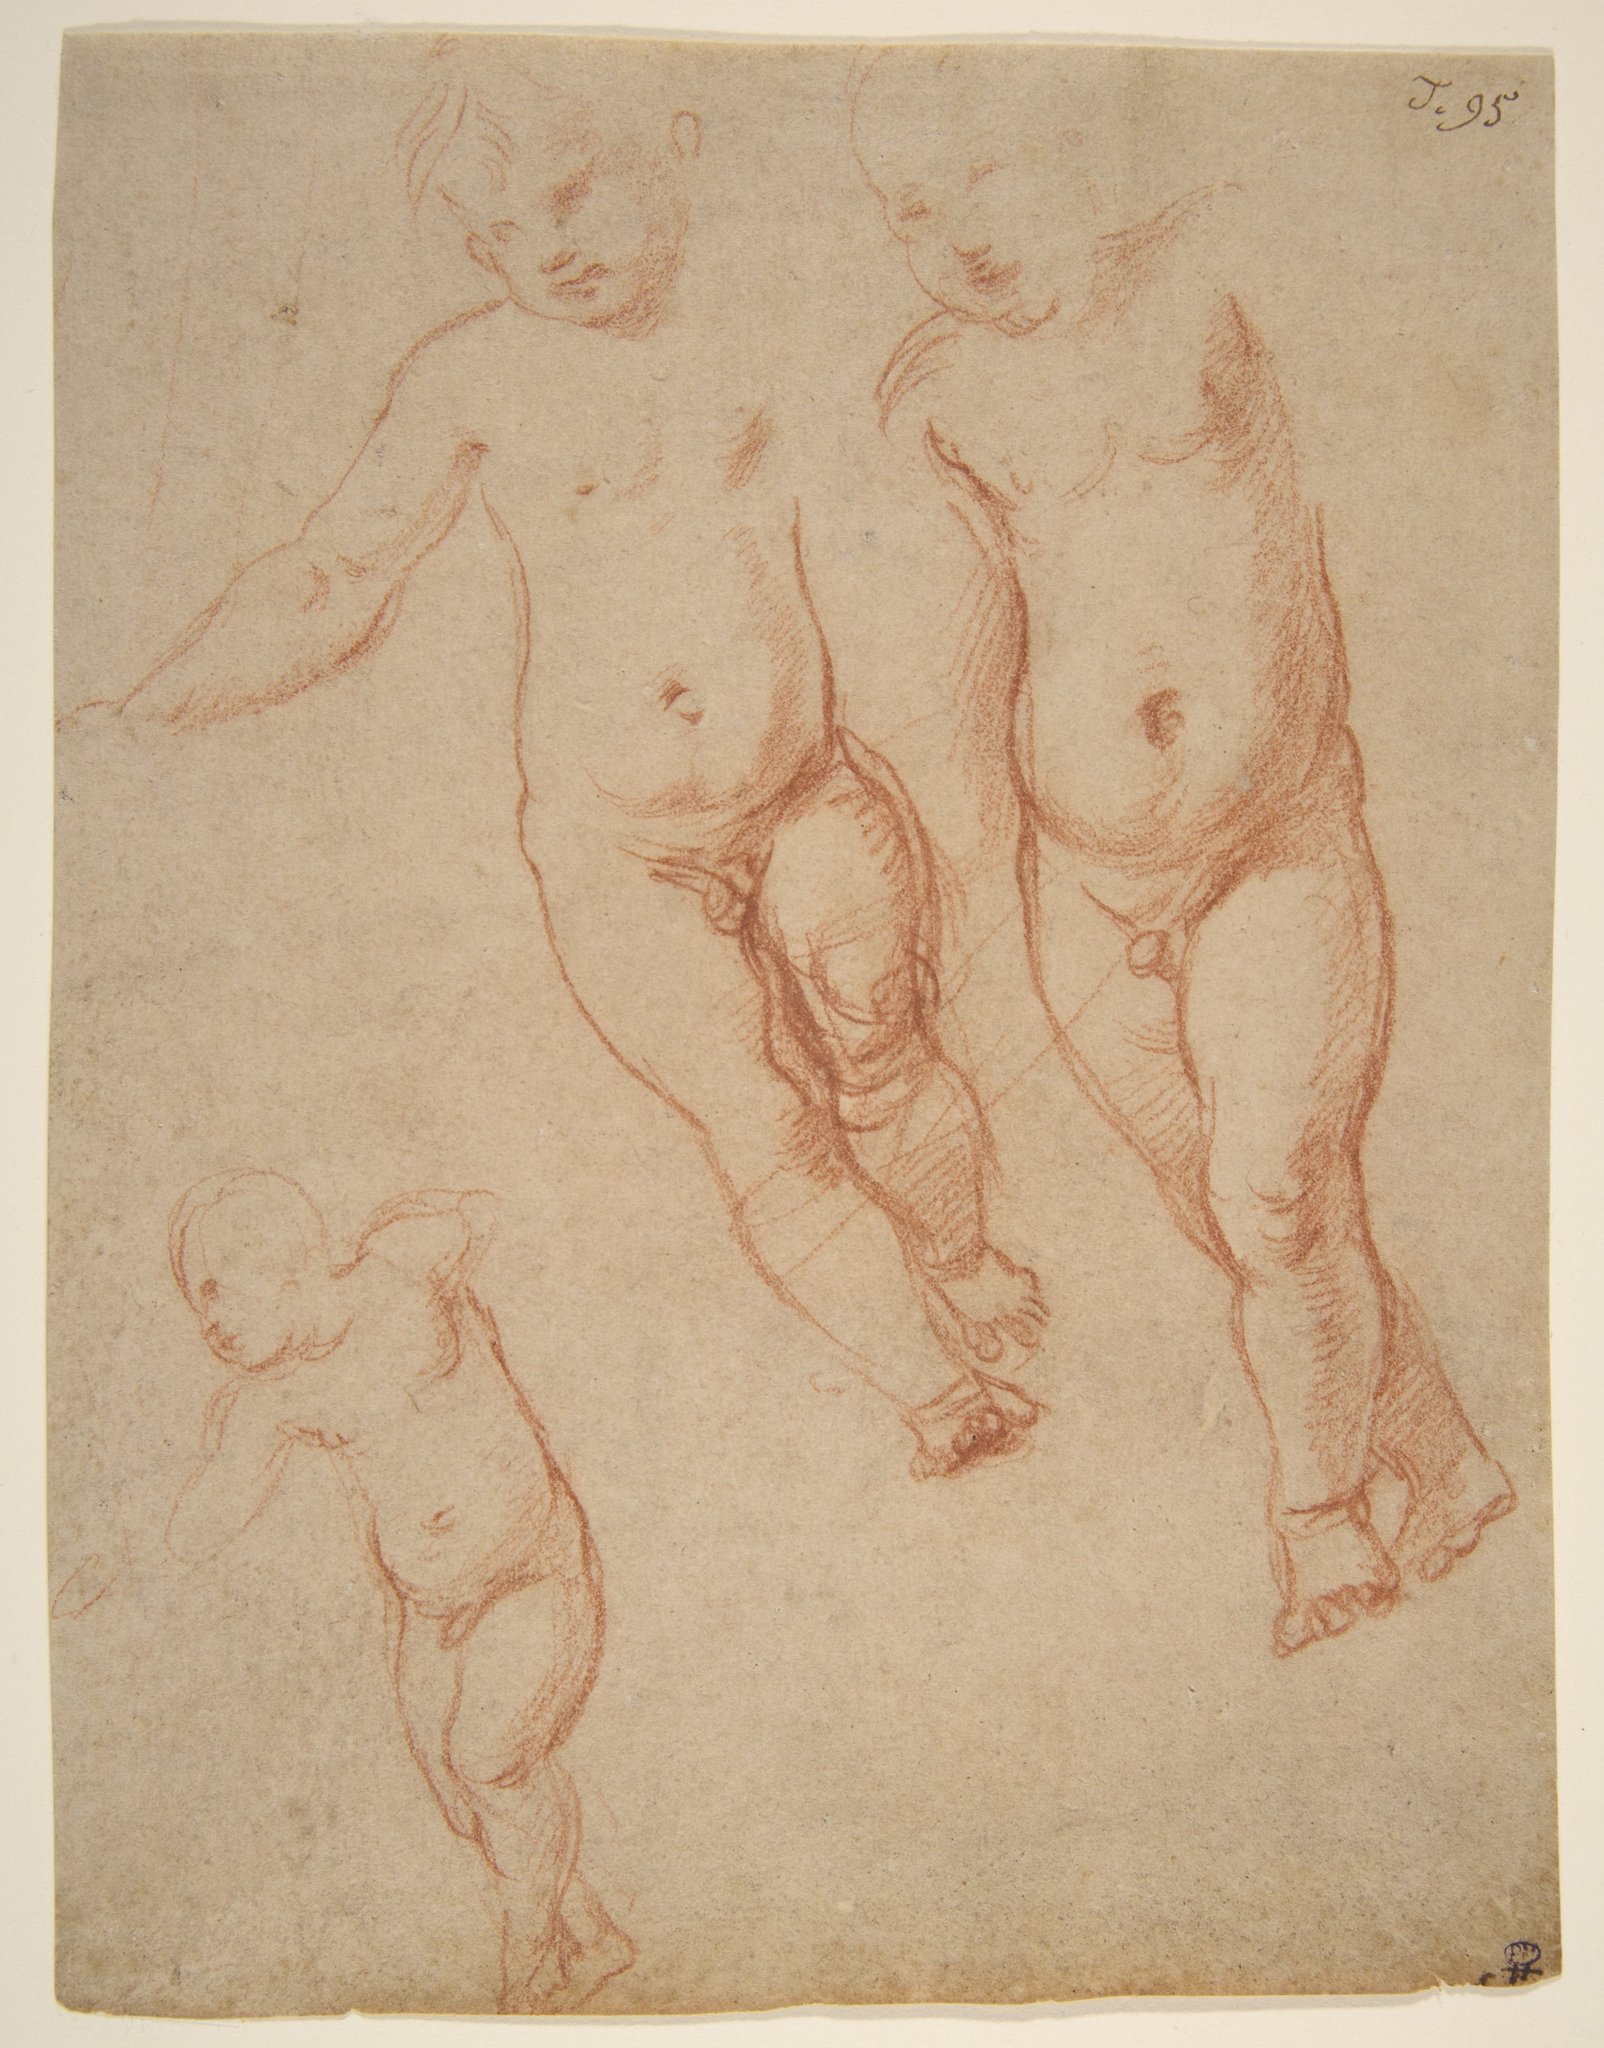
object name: drawing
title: Studies of the Christ Child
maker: raphael (raffaello sanzio or santi)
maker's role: artist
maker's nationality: italian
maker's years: 1483-1520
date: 1513-1514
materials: chalk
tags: children,christ